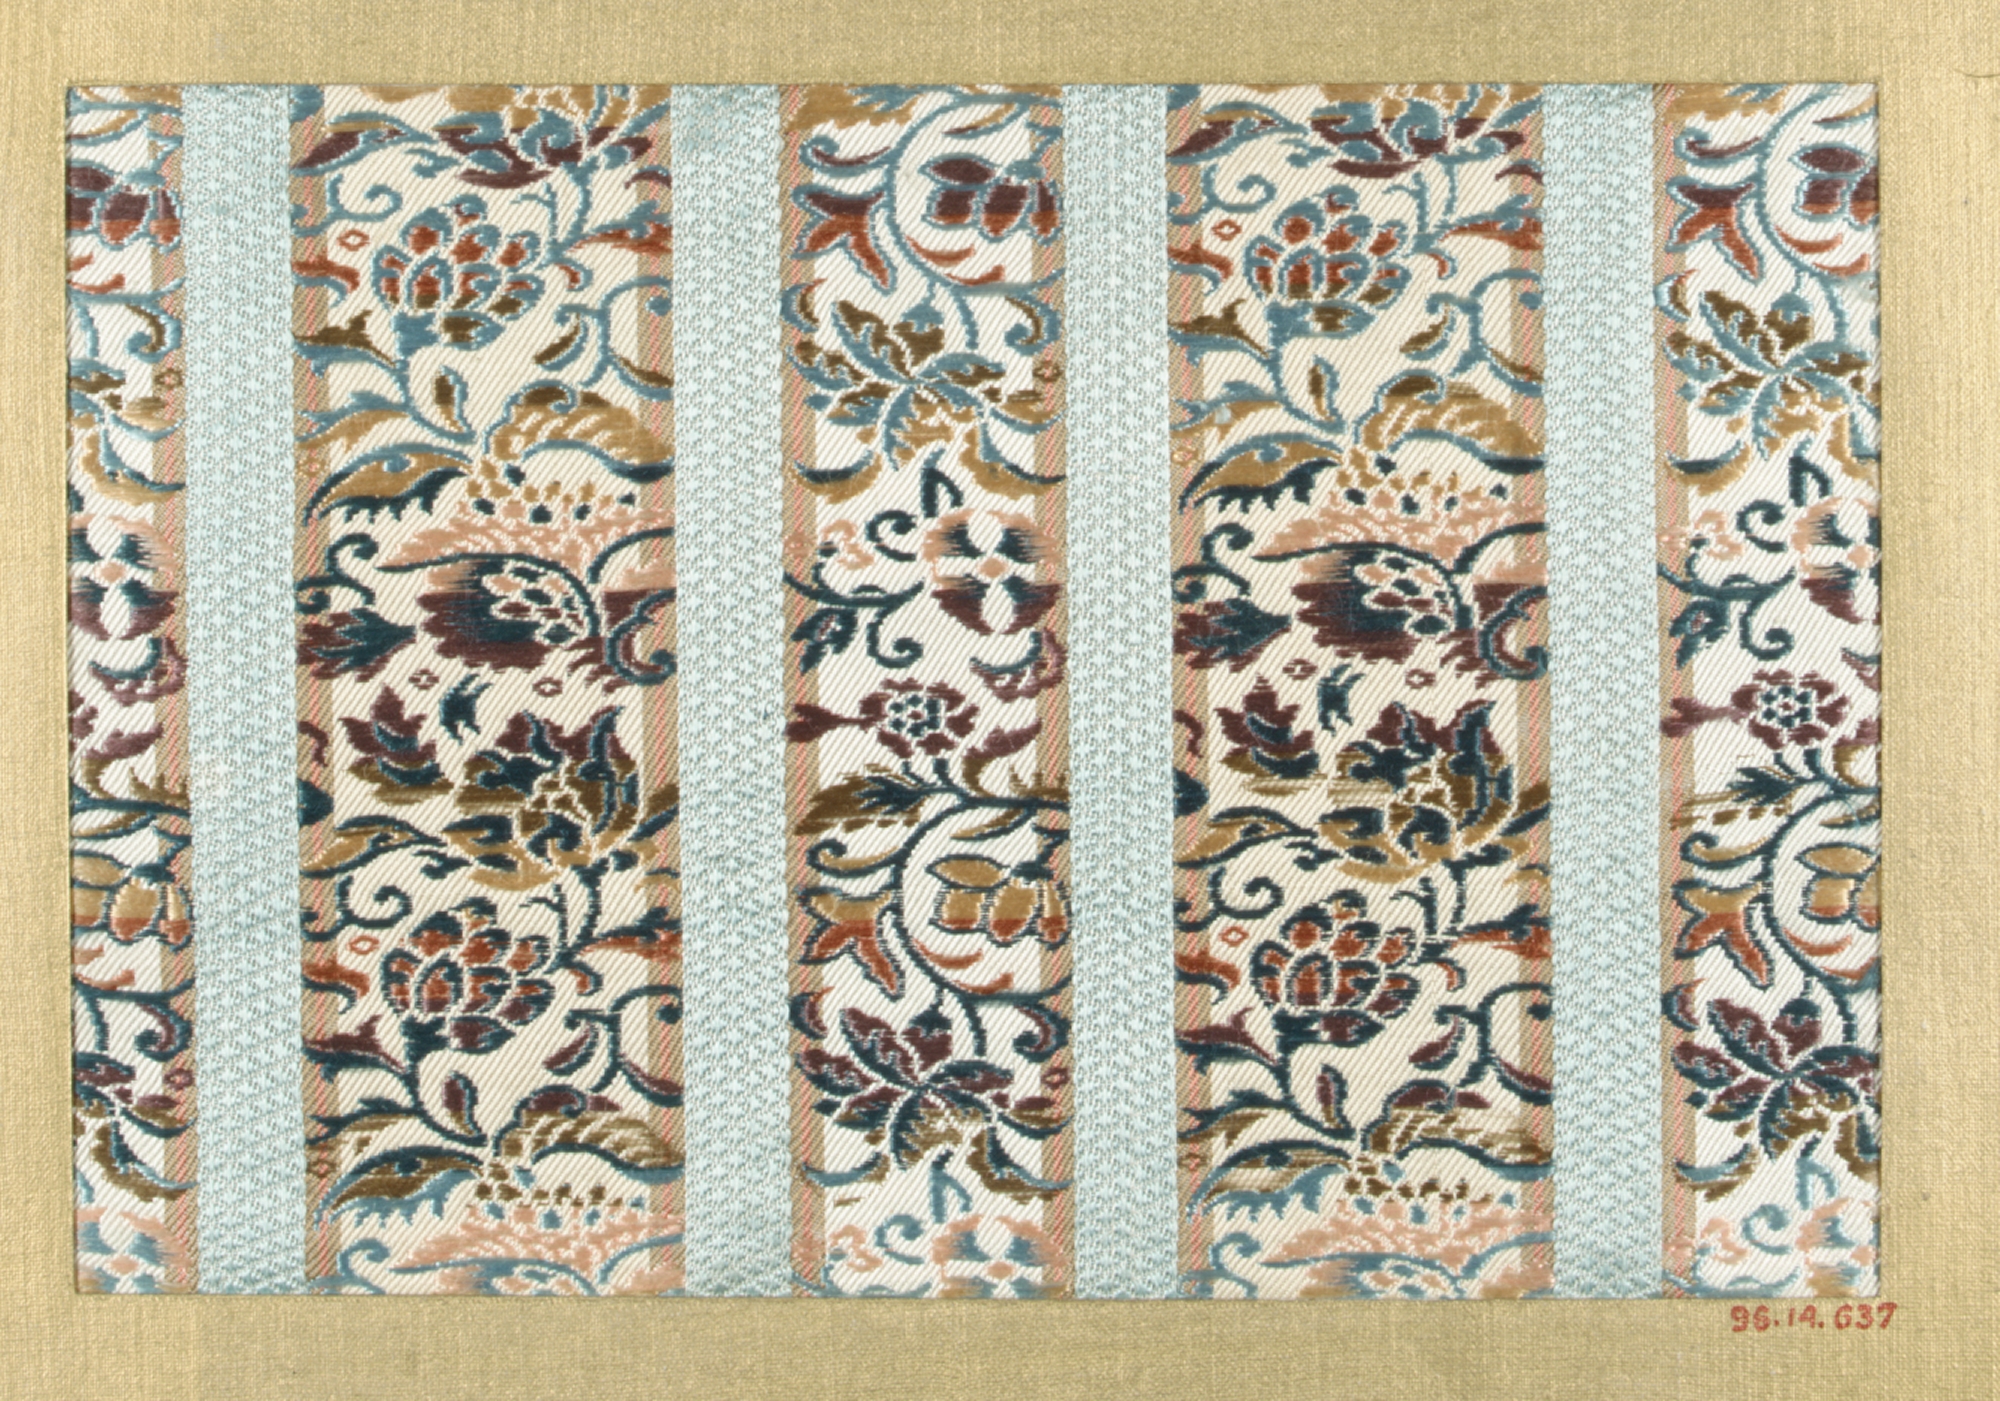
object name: piece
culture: japanese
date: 1701-1900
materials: silk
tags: leaves